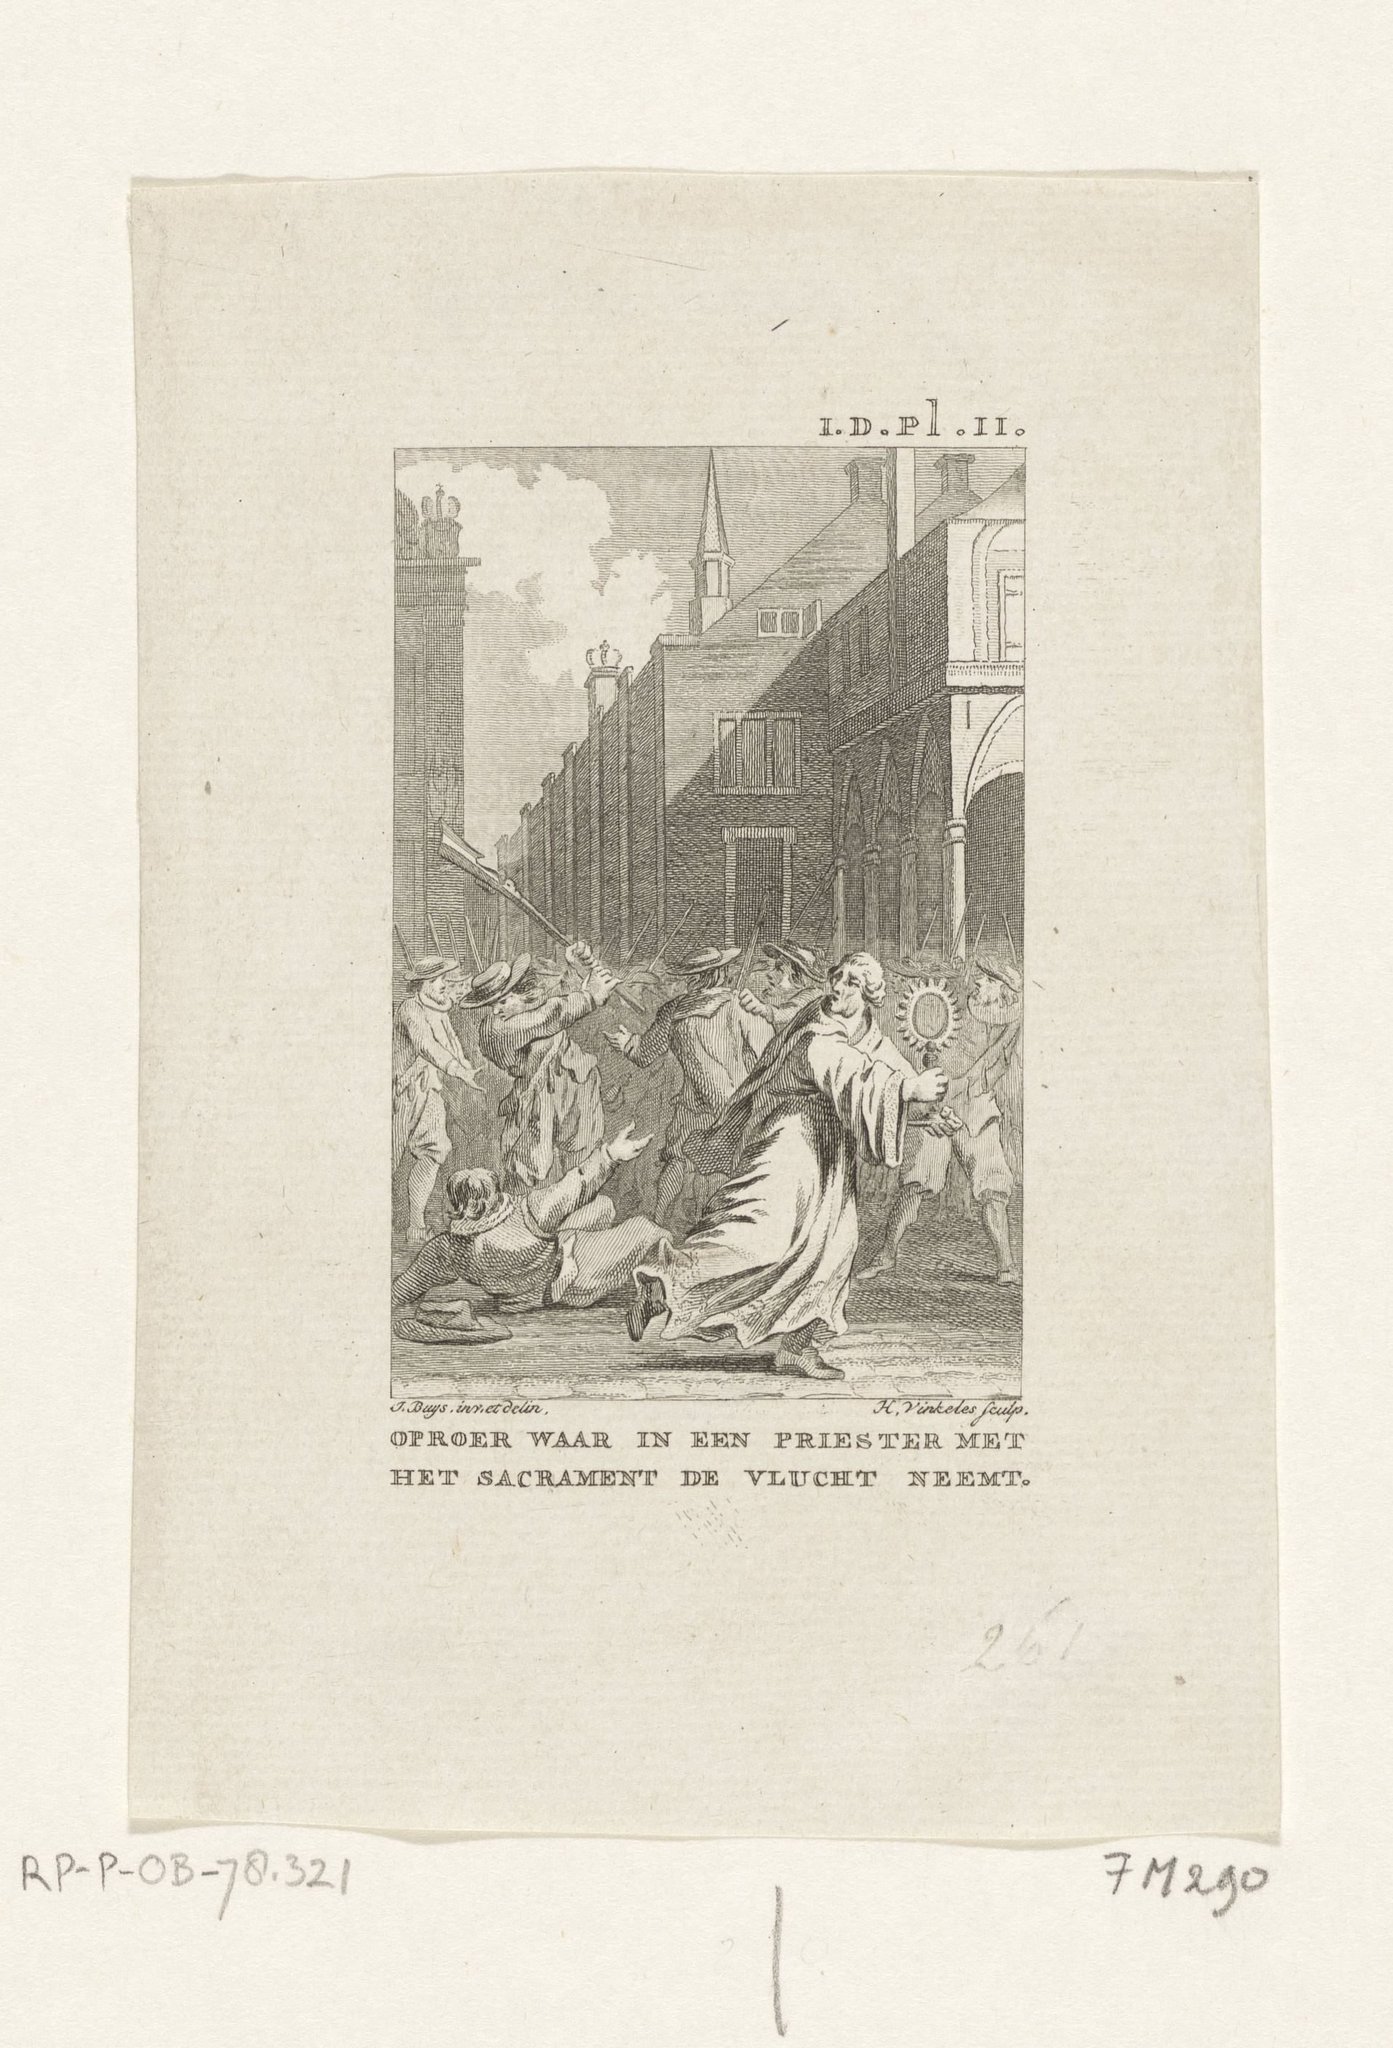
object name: print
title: Priester brengt het sacrament in veiligheid tijdens oproer in Amsterdam, 1444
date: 1786-1792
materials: paper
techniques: etching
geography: netherlands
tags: street-fights, riots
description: Illustratie voor: J. Fokke, Amsteldam en zyne geschiedenissen, in’t kort, 6 delen, J. Allart, Amsterdam 1788-1792, dl. I, pl. II.